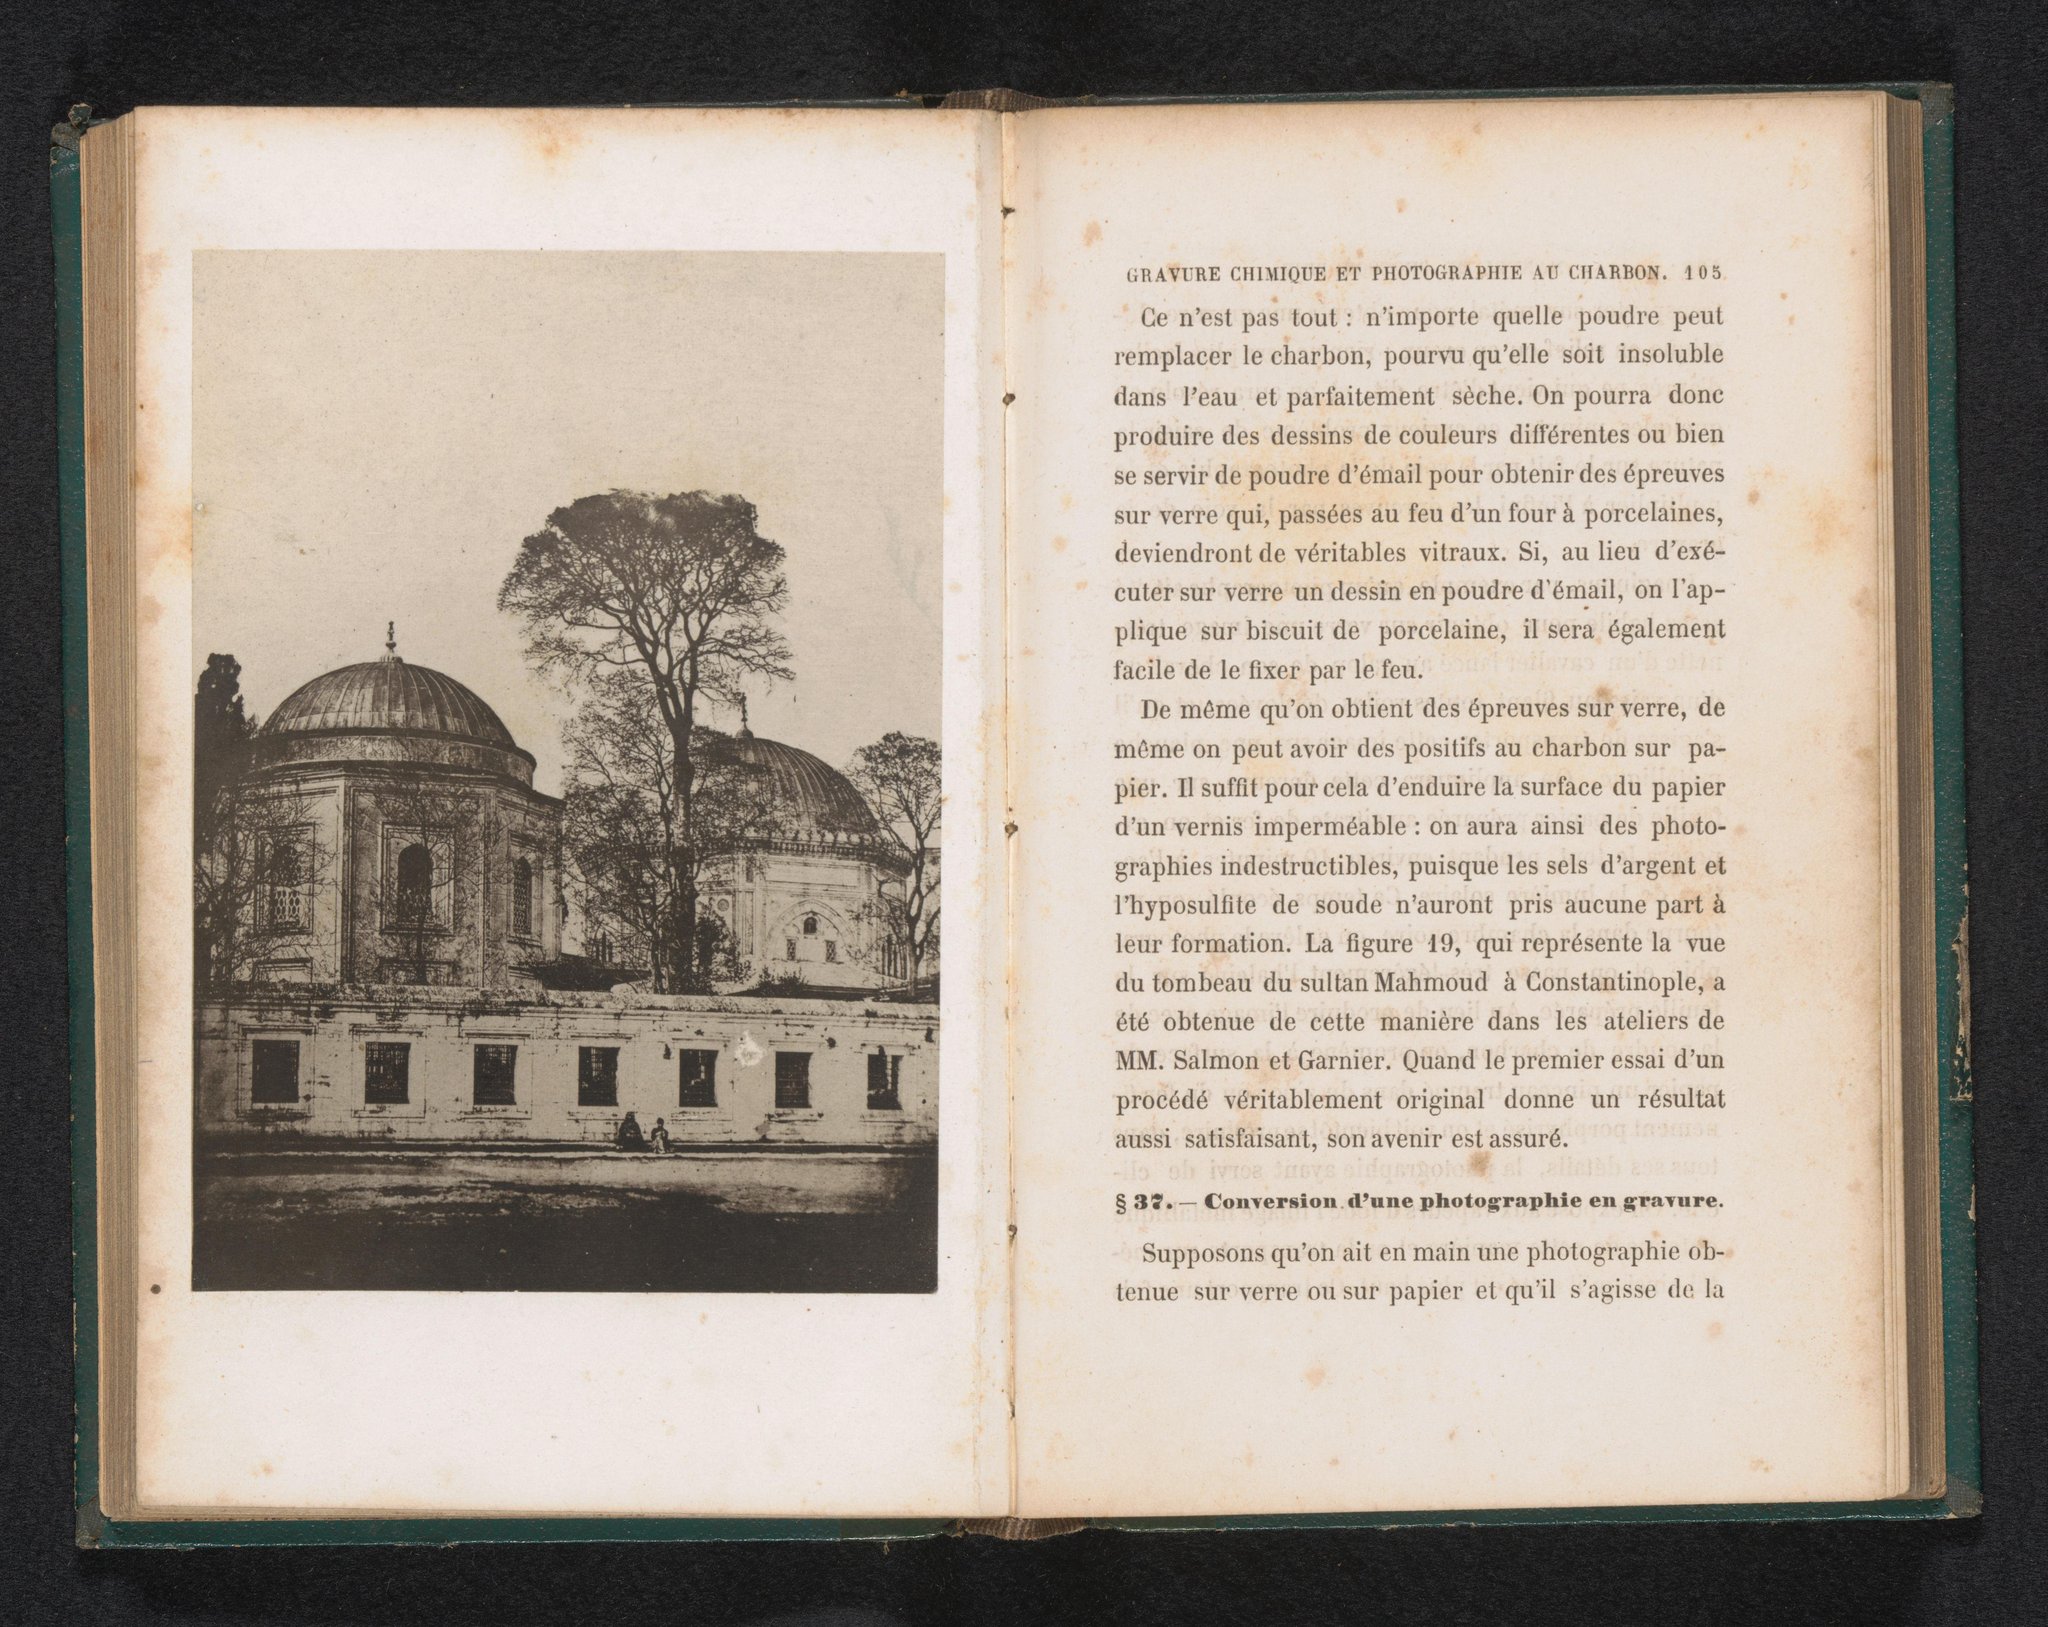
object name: photograph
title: Gezicht op het mausoleum van sultan Mahmoud in Istanboel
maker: james robertson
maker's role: fotograaf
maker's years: 1813-1888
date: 1854-1859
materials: paper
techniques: carbon print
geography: istanbul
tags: mausoleum